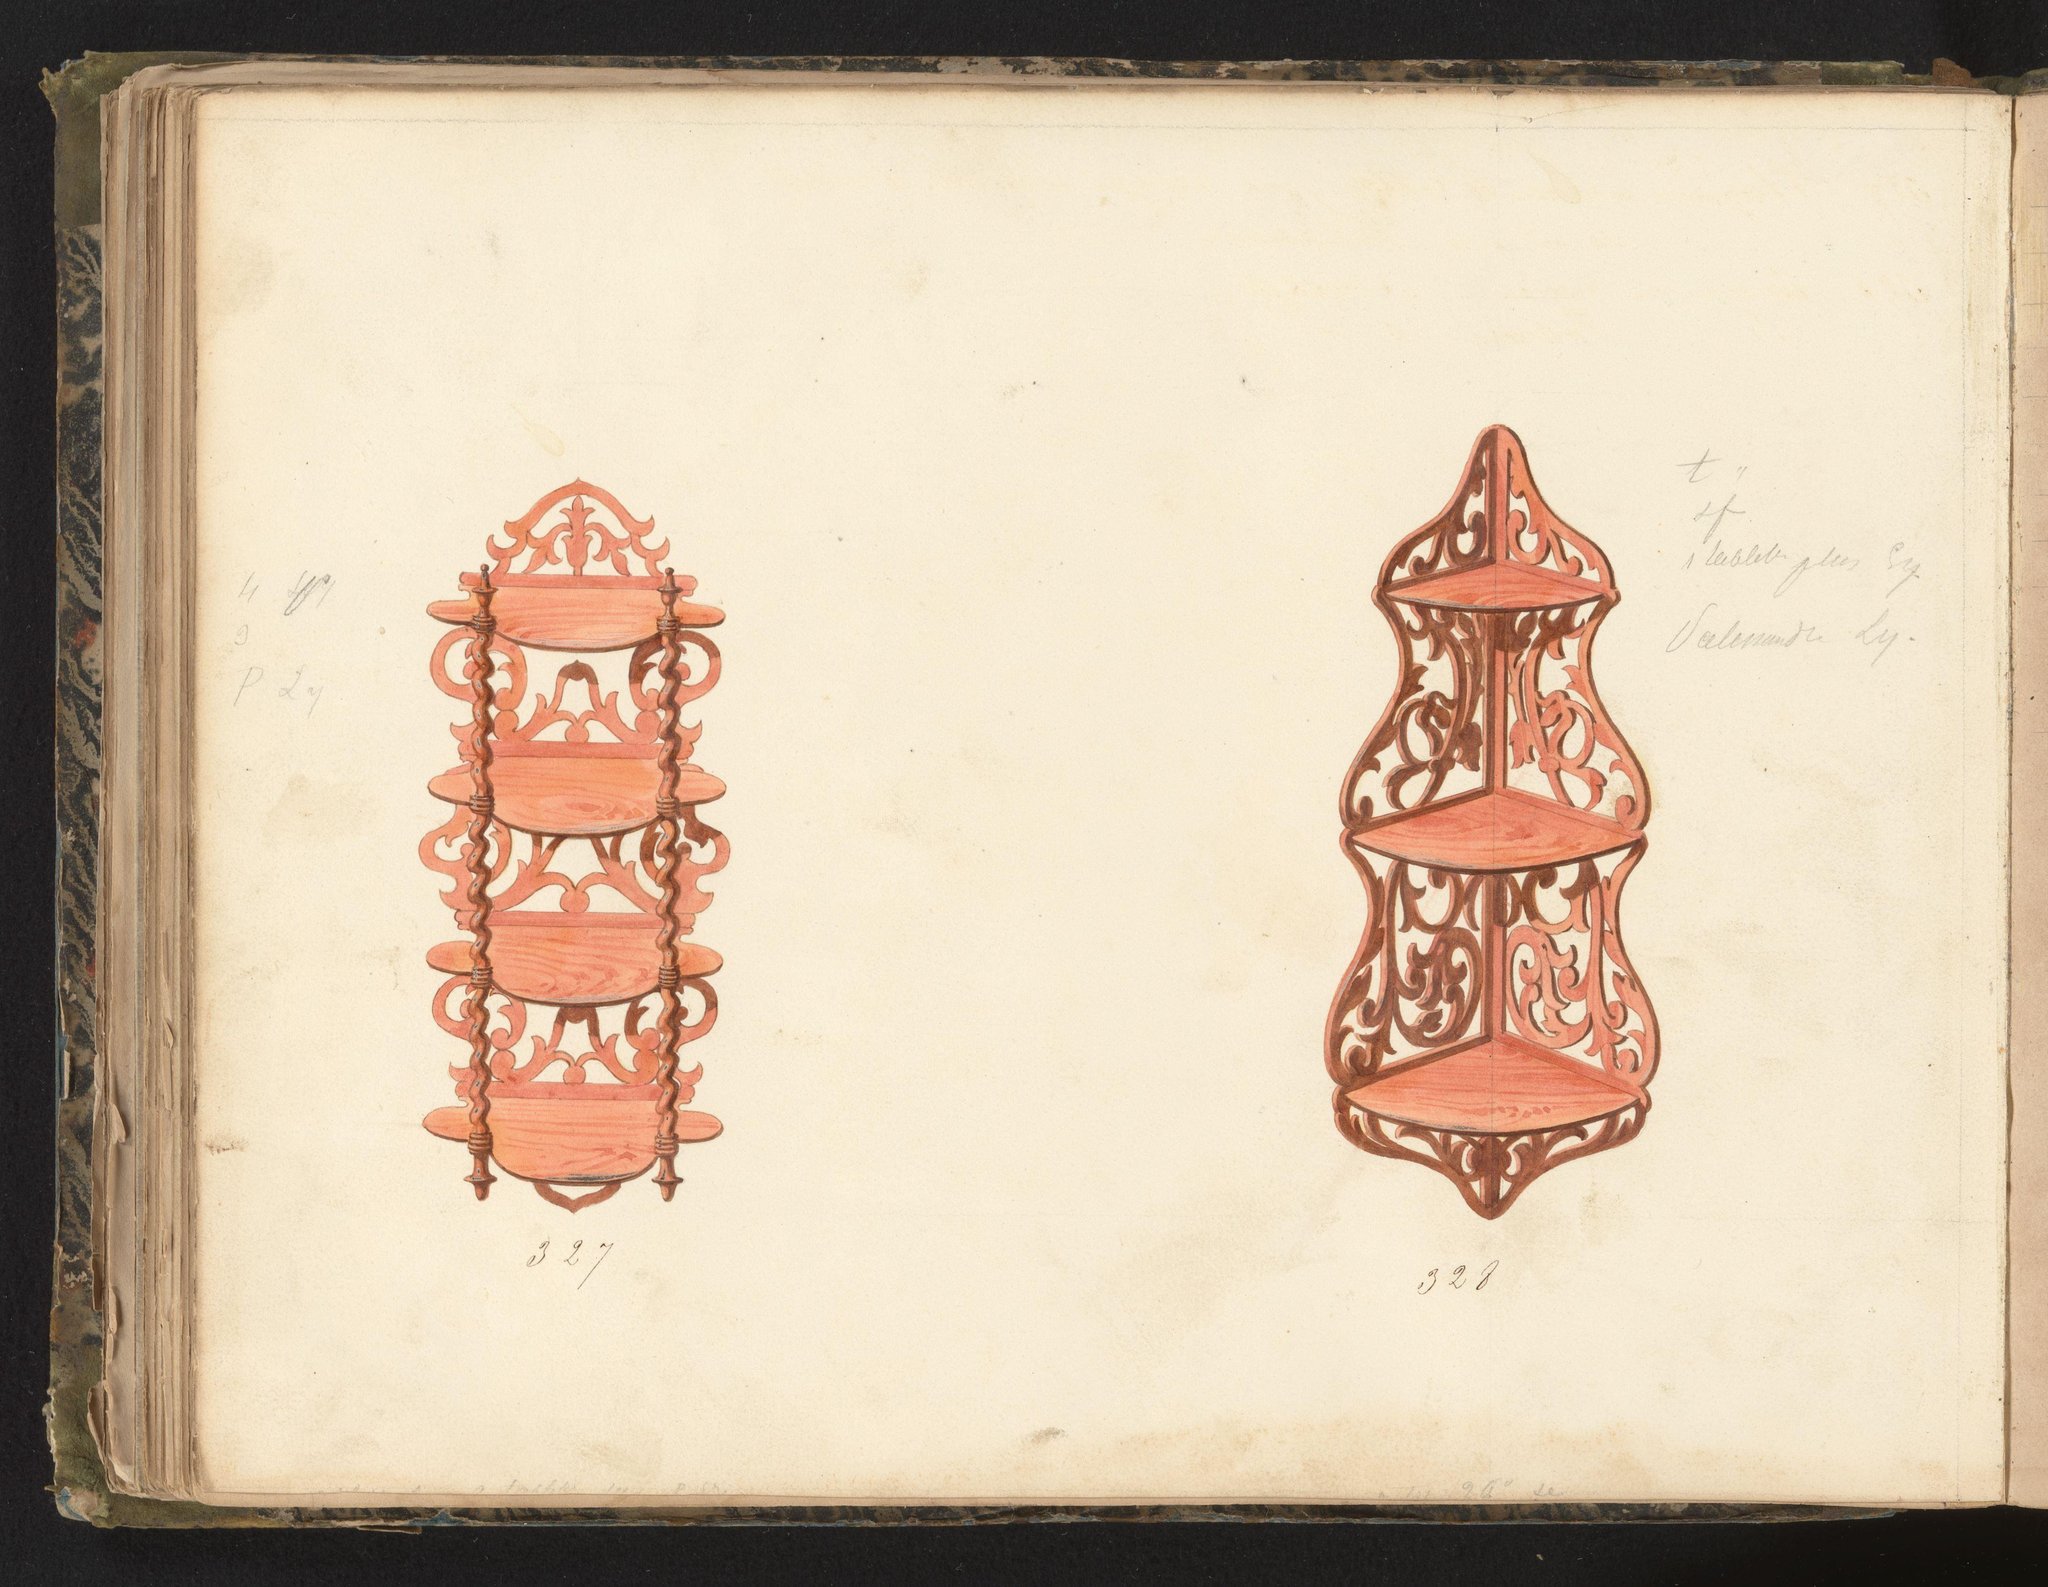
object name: drawing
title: Twee ontwerpen voor etagères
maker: Anonymous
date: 1825-1839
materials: ink, paper, pencil, watercolor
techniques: brush, pen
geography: paris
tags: what-not (+ wood and other phytogenic material)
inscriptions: inscription: ‘327 Etagere acajou 4 tablettes fond découpé colonnes torses la même palissandre 328 Encoignure acajou 3 tablettes ‘’…’’ palissandre 3 ‘’’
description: Twee ontwerpen voor opengewerkte etagères van mahoniehout. Het blad op de achterzijde genummerd: 30, het tegenoverliggende blad met informatie over de afgebeelde meubelen genummerd: 30 bis. Onderdeel van een album met 80 bladen met tekeningen en een prent van gefineerde en gelakte meubelen, alsmede zitmeubelen.